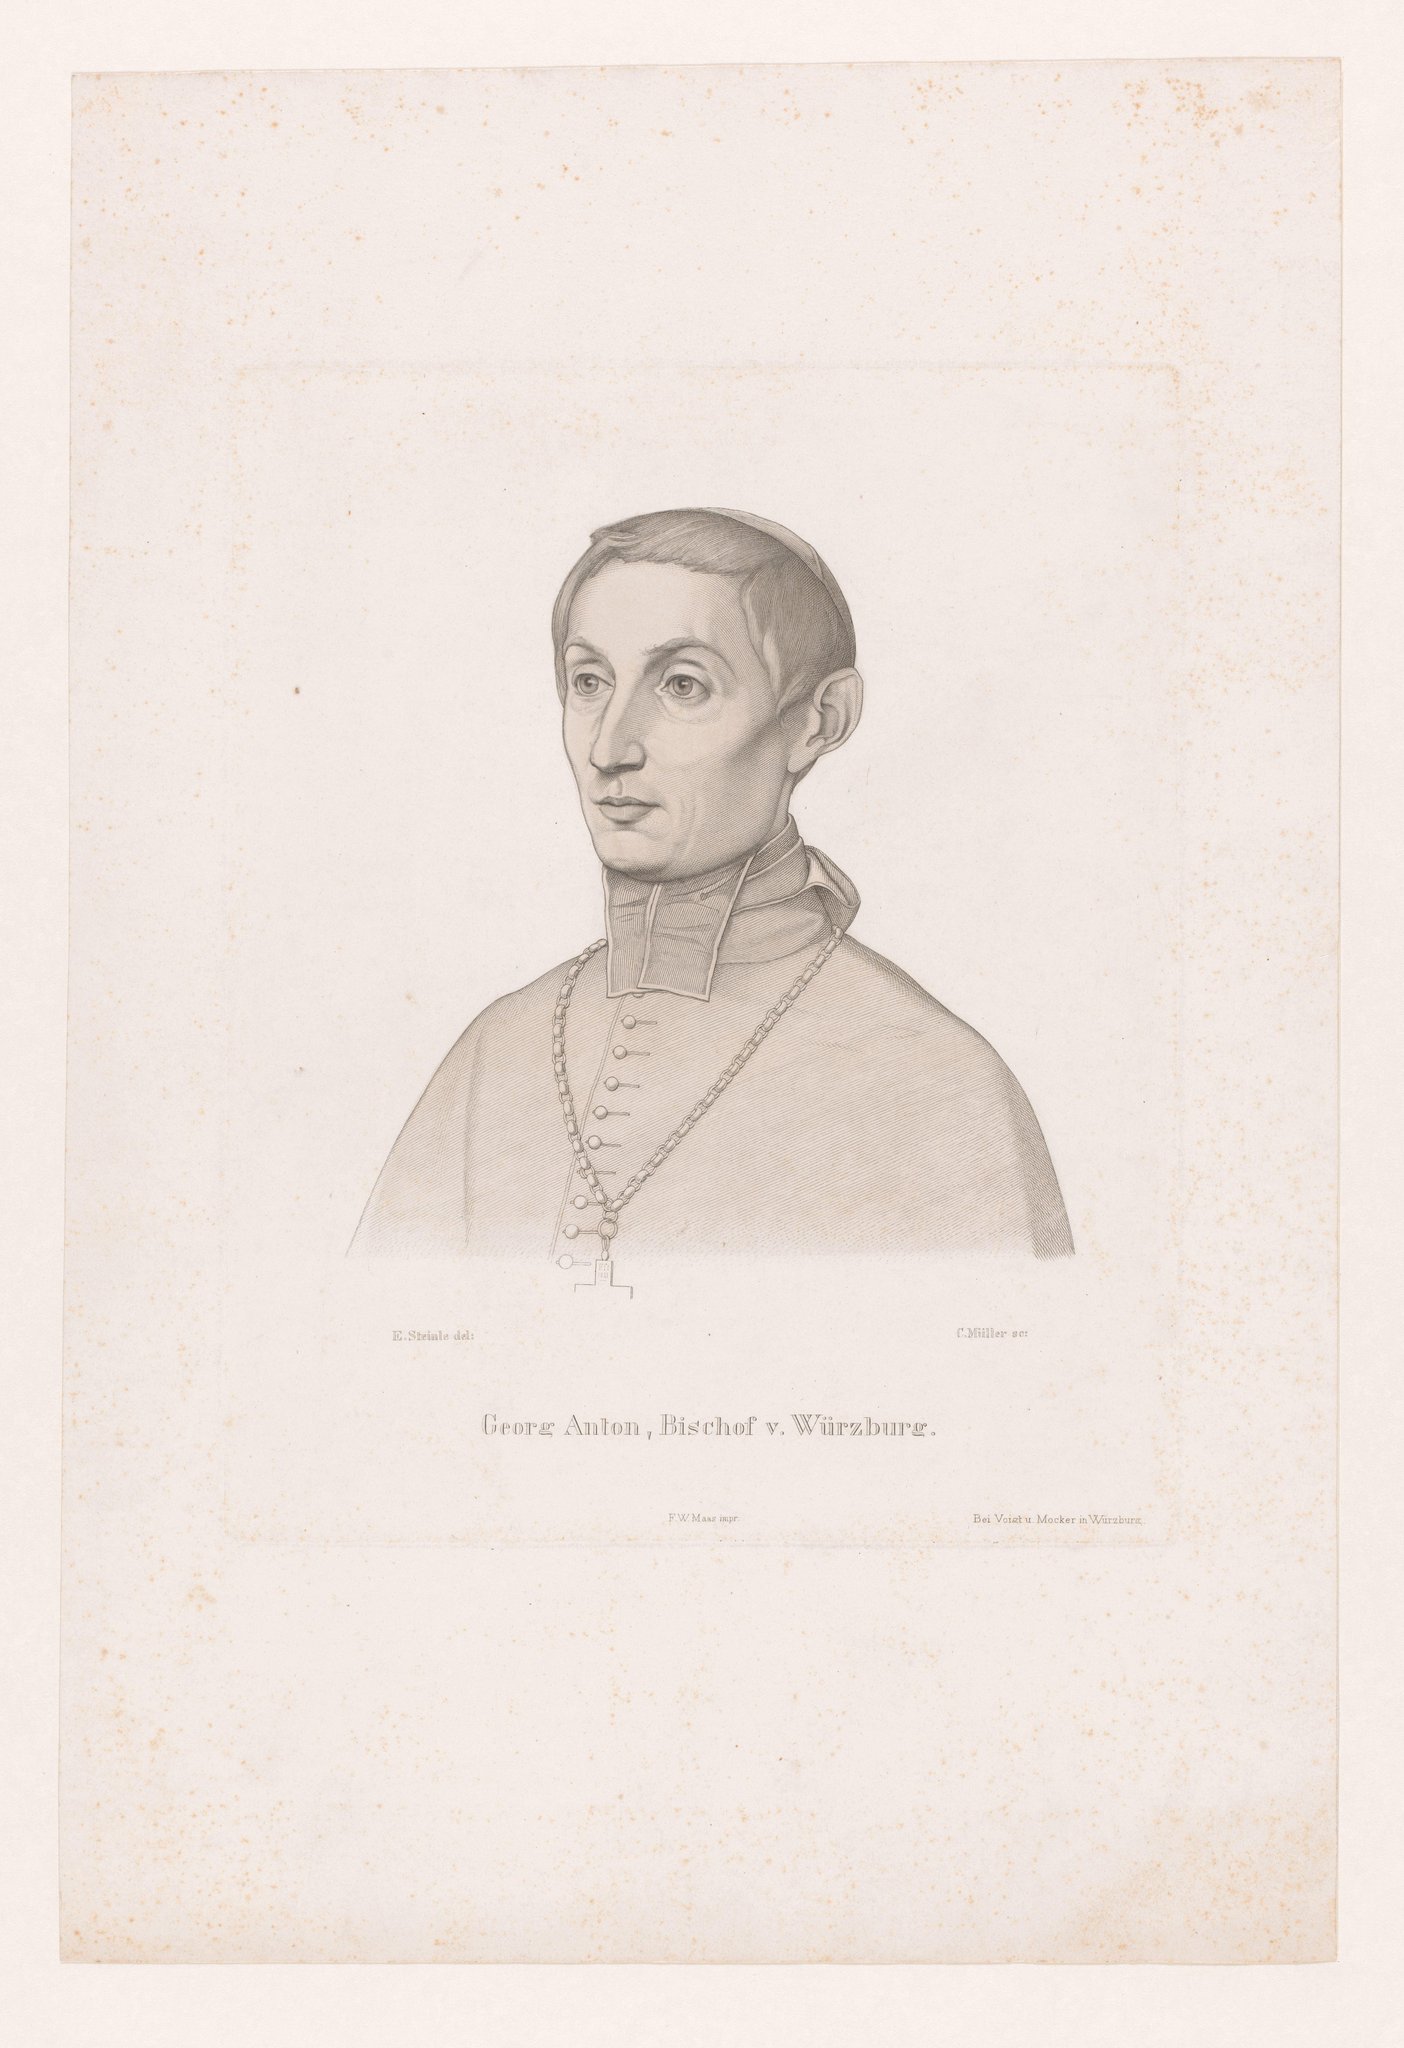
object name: print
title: Portret van Georg Anton Stahl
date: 1825-1899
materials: paper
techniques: etching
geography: würzburg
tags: liturgical vestments, canonicals, historical persons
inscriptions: collector's mark: Lugt 2228